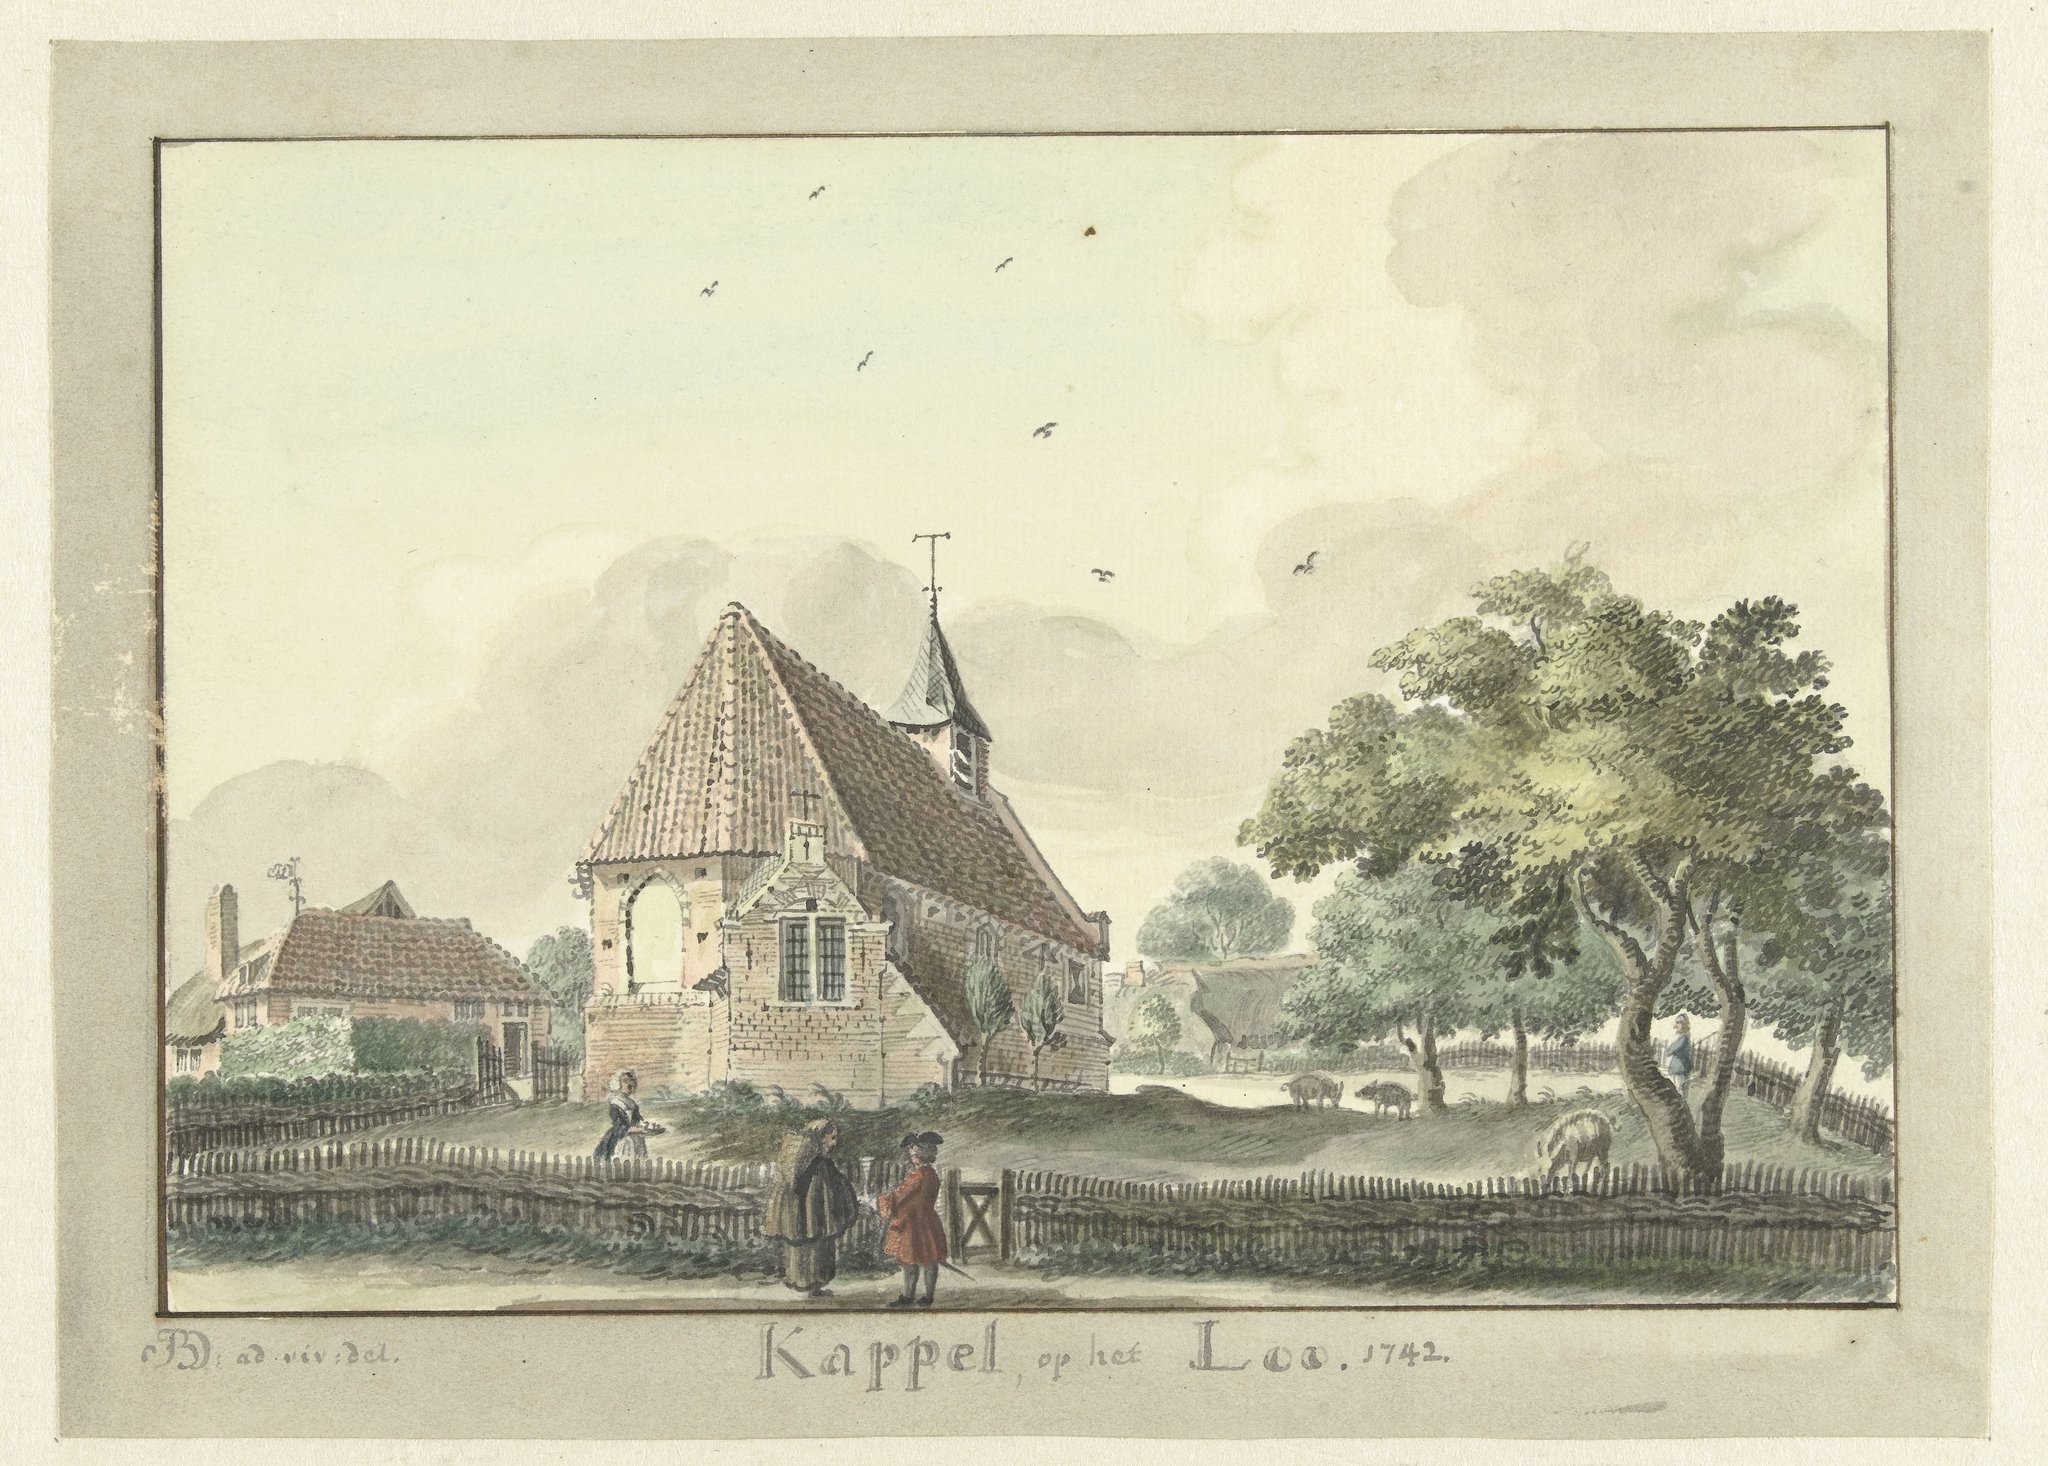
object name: drawing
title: Kapel op 't Loo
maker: jan de beijer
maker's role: draughtsman, print maker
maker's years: 1703-1780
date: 1742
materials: ink, paper, watercolor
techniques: brush, pen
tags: church (exterior)